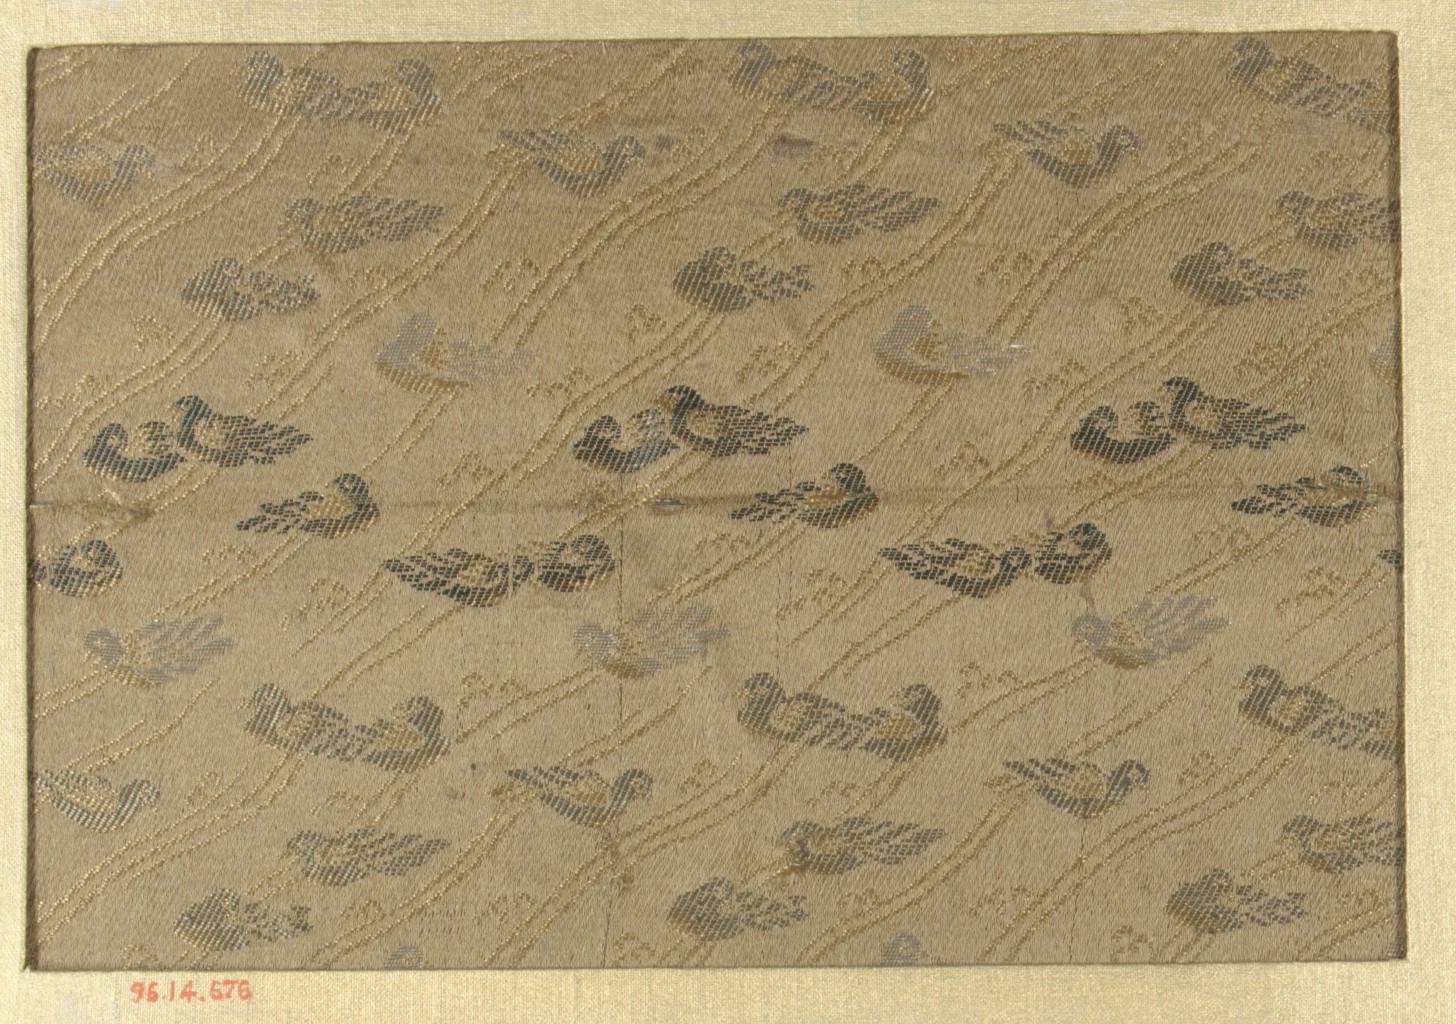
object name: piece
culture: japanese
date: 1701-1900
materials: silk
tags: birds